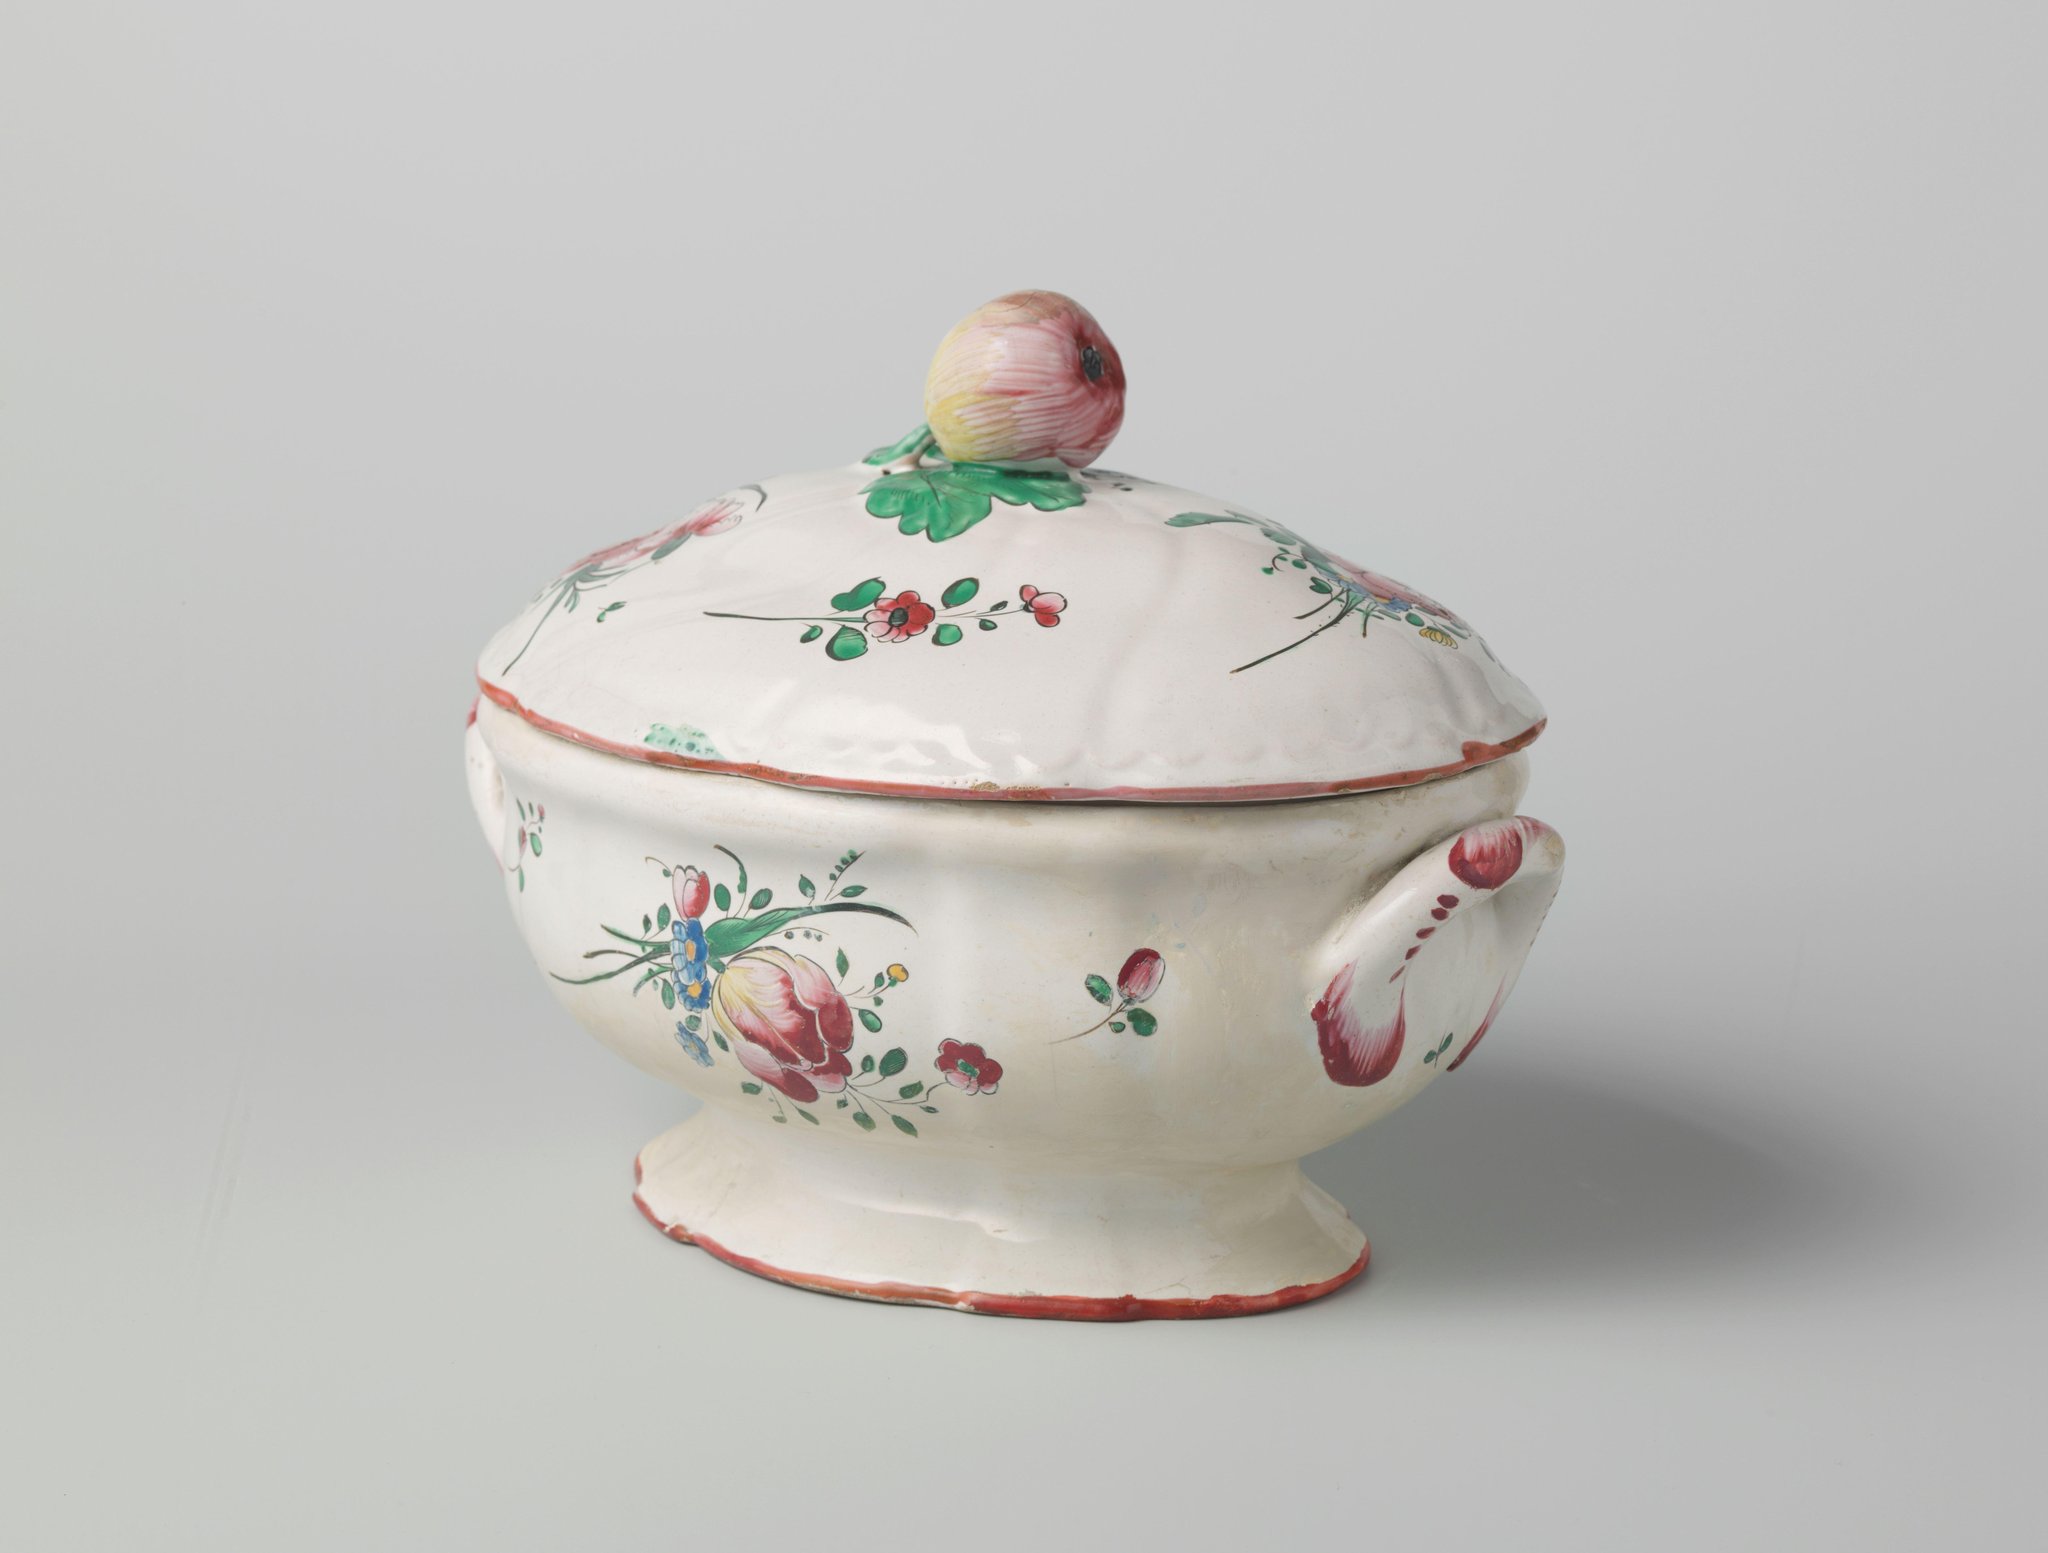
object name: lid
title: Deksel van terrine, beschilderd met bloemen en bloemboeketten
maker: Anonymous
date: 1760-1780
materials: earthenware, glaze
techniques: painted, polychromy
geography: france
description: Deksel van ovale soepterrine van veelkleurig beschilderde faience. Het deksel heeft een knop in de vorm van een appel. Beschilderd met bloemen en bloemboeketten. en heeft twee oren tegen de schaal aan.